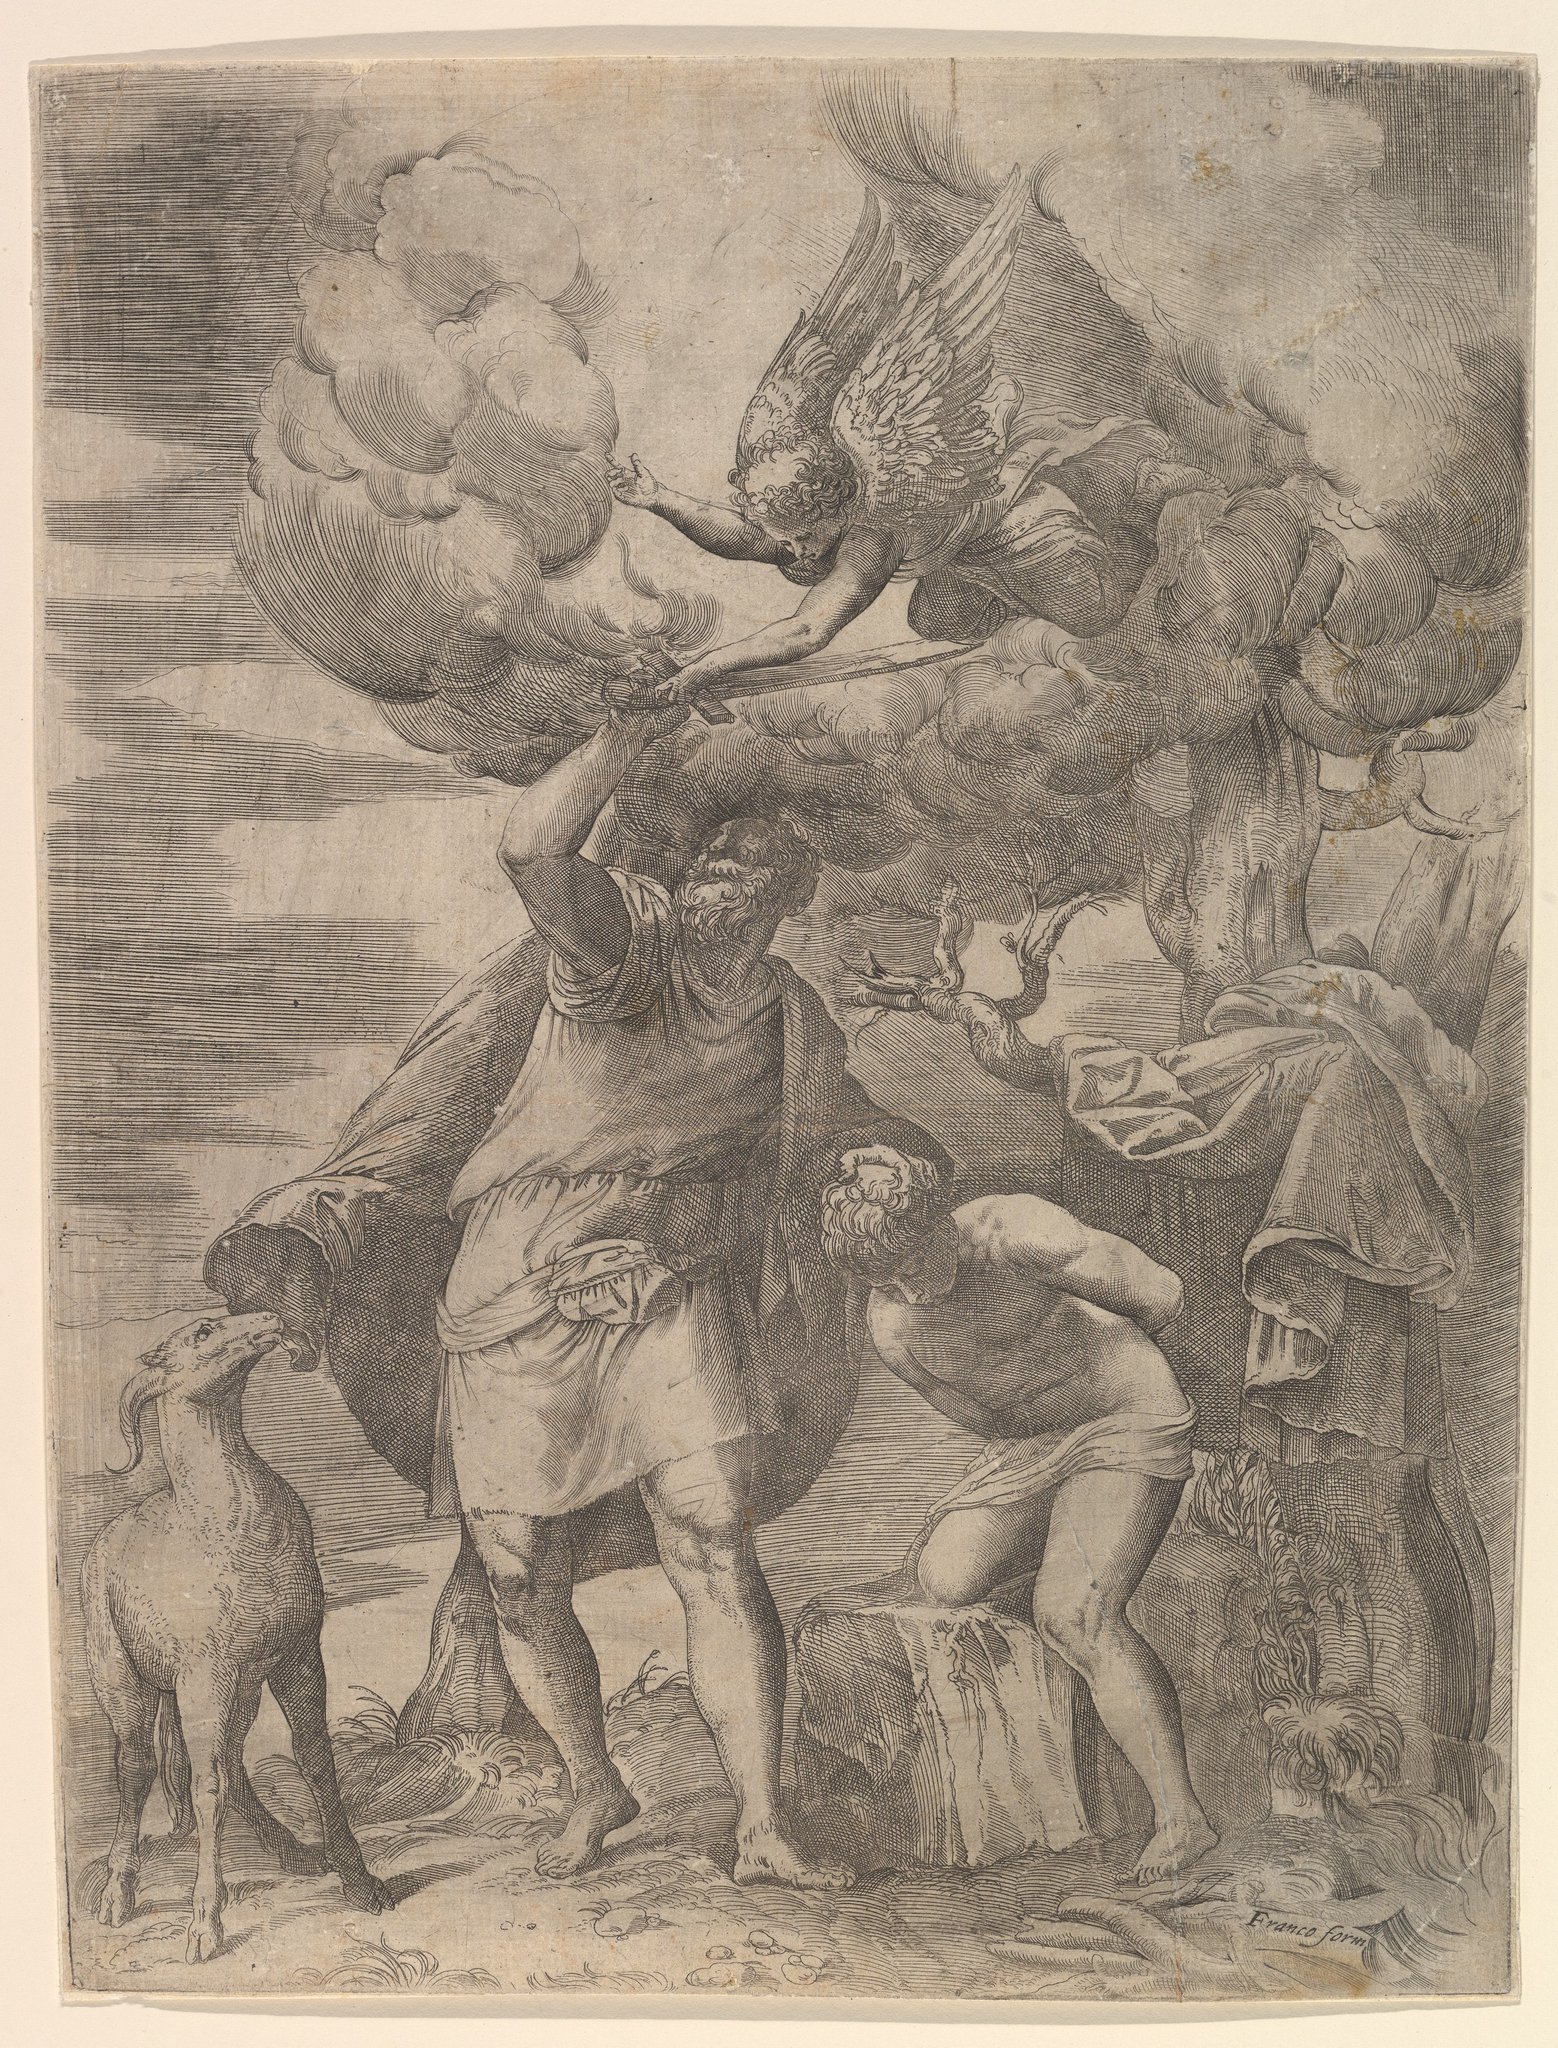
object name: print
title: The Angel Staying the Arm of Abraham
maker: battista franco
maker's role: artist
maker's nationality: italian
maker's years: 1510-1561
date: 1552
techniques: engraving, etching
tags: animals,angels,abraham